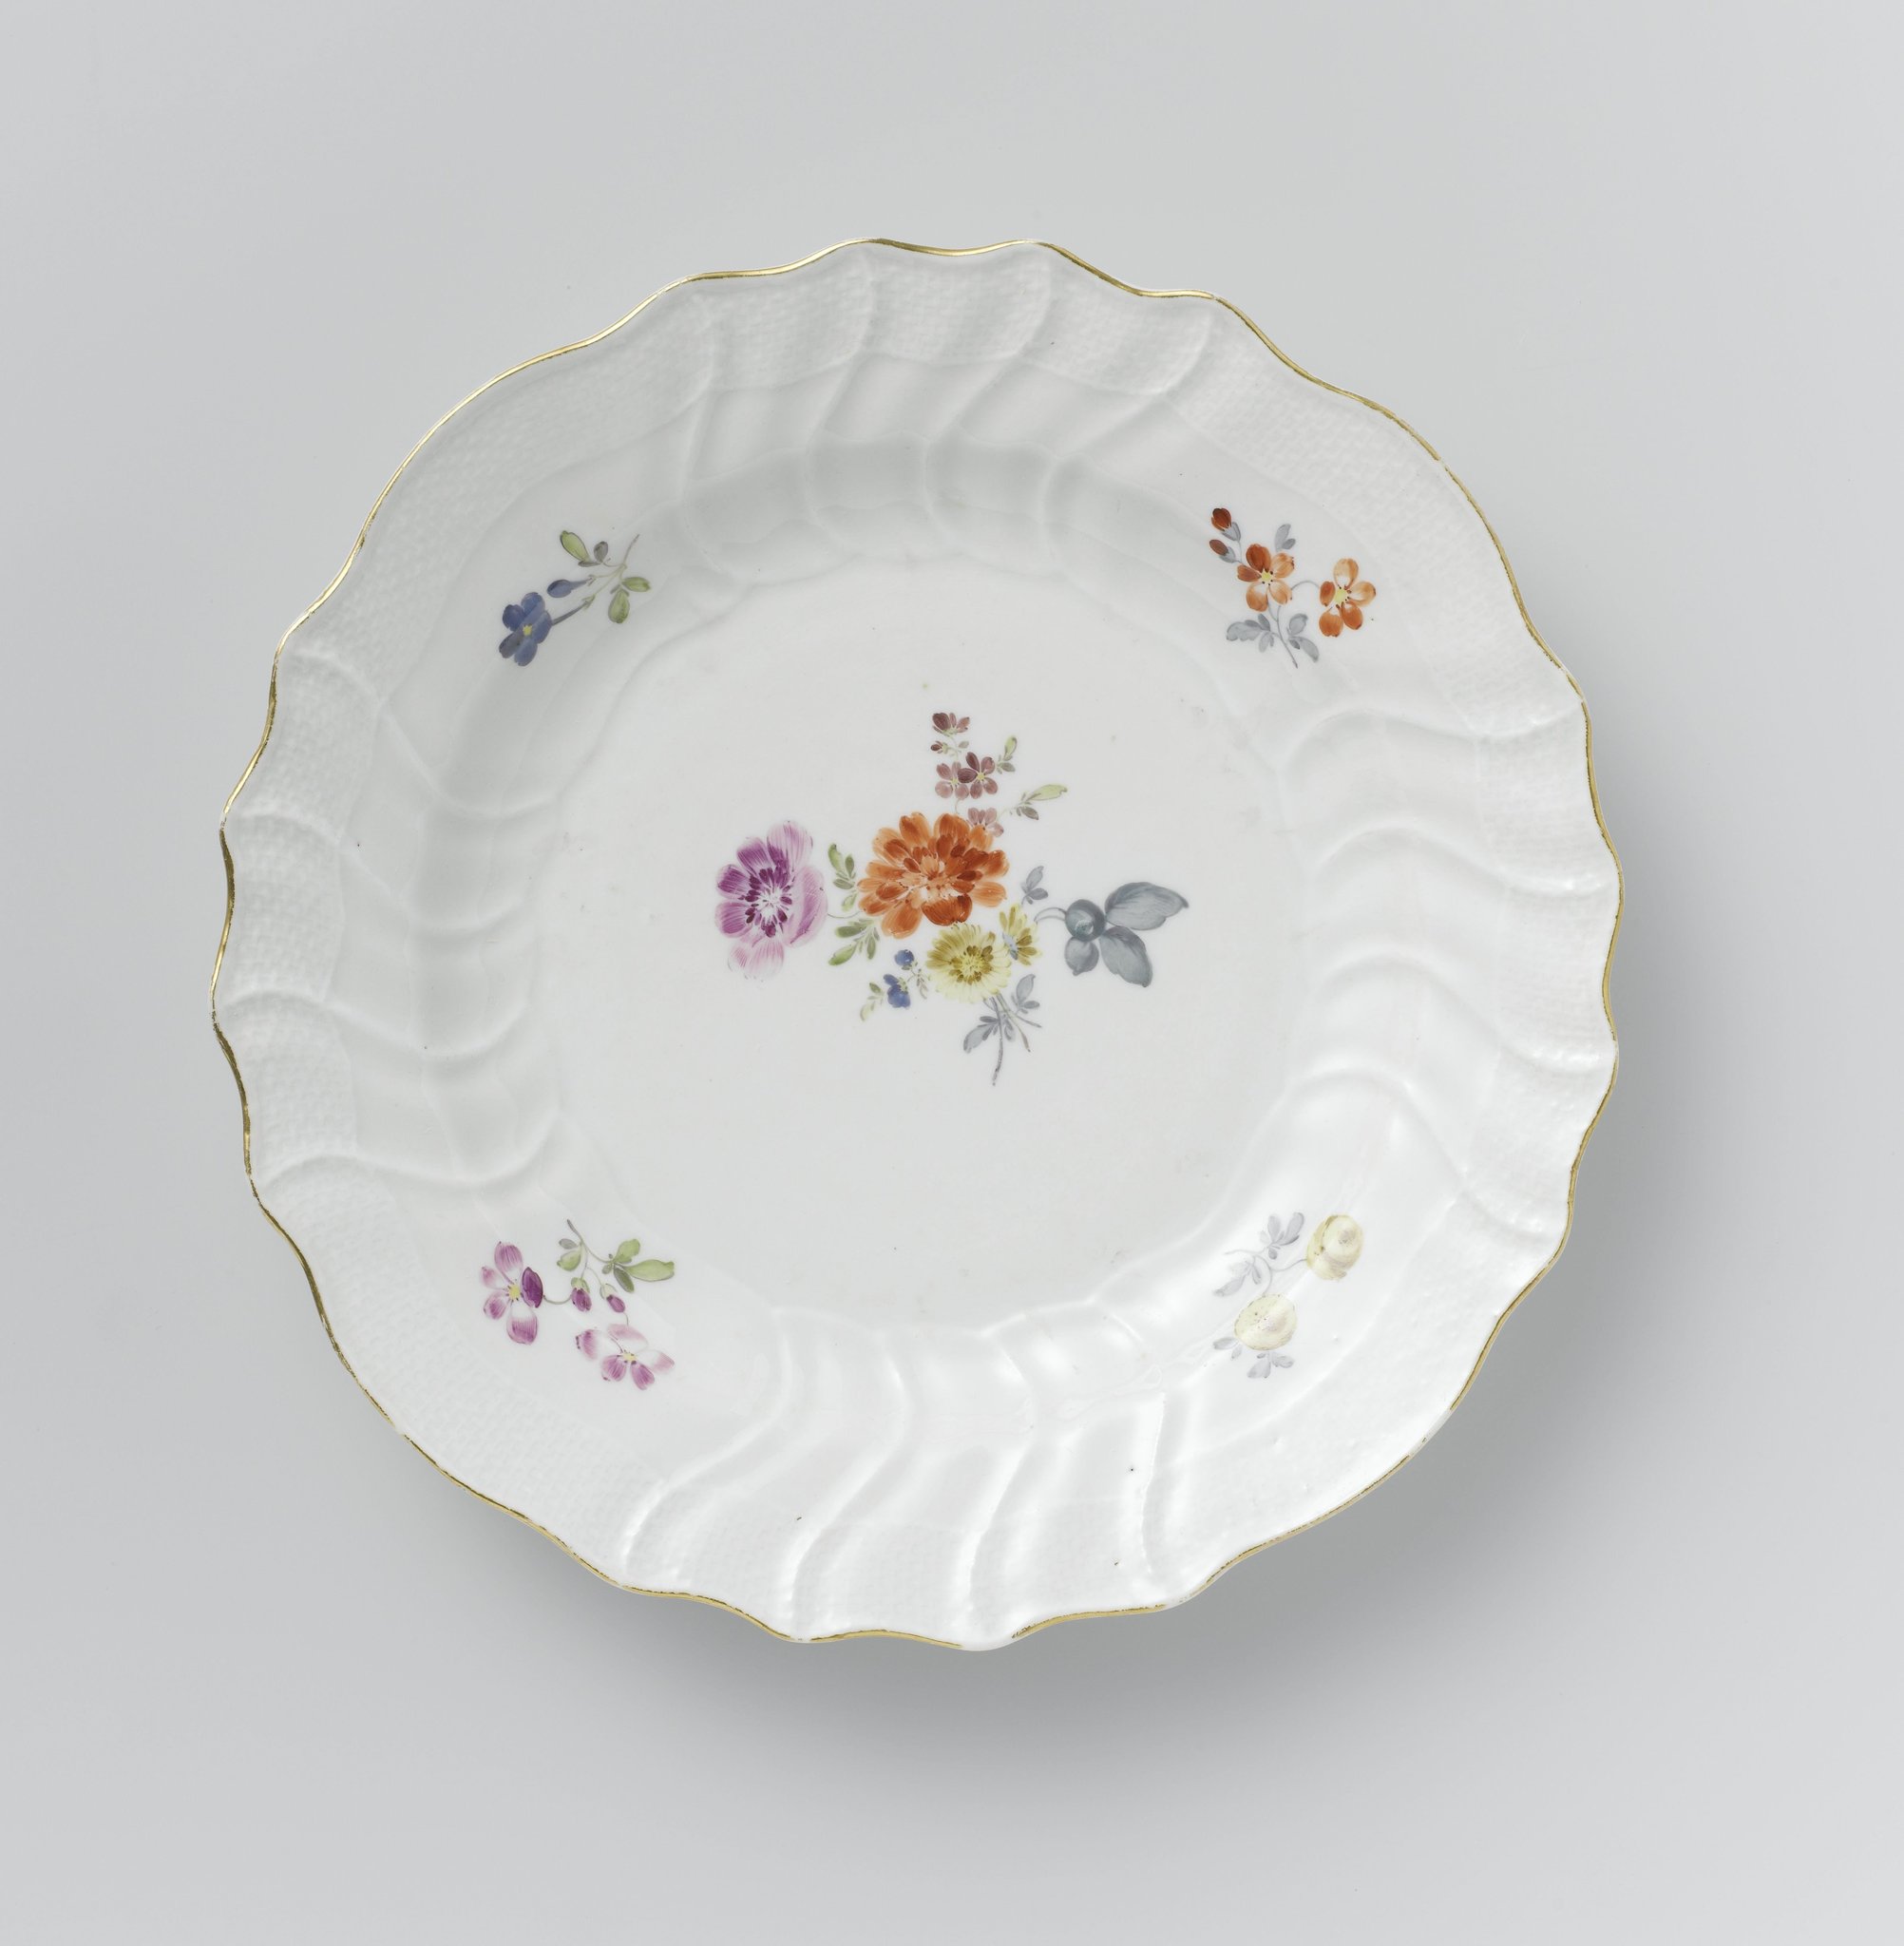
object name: plate dish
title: Bord, veelkleurig beschilderd met Deutsche Blumen, insekten en vruchten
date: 1750-1760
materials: porcelain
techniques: painted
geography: meissen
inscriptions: factory mark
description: Rond bord van beschilderd porselein. Het bord is beschilderd met Deutsche Blumen, insekten en vruchten. De rand is in reliëf versierd met het Neuozier-patroon. Het bord is gemerkt en hoort bij een servies (BK-17474-1 t/m BK-17474-253).